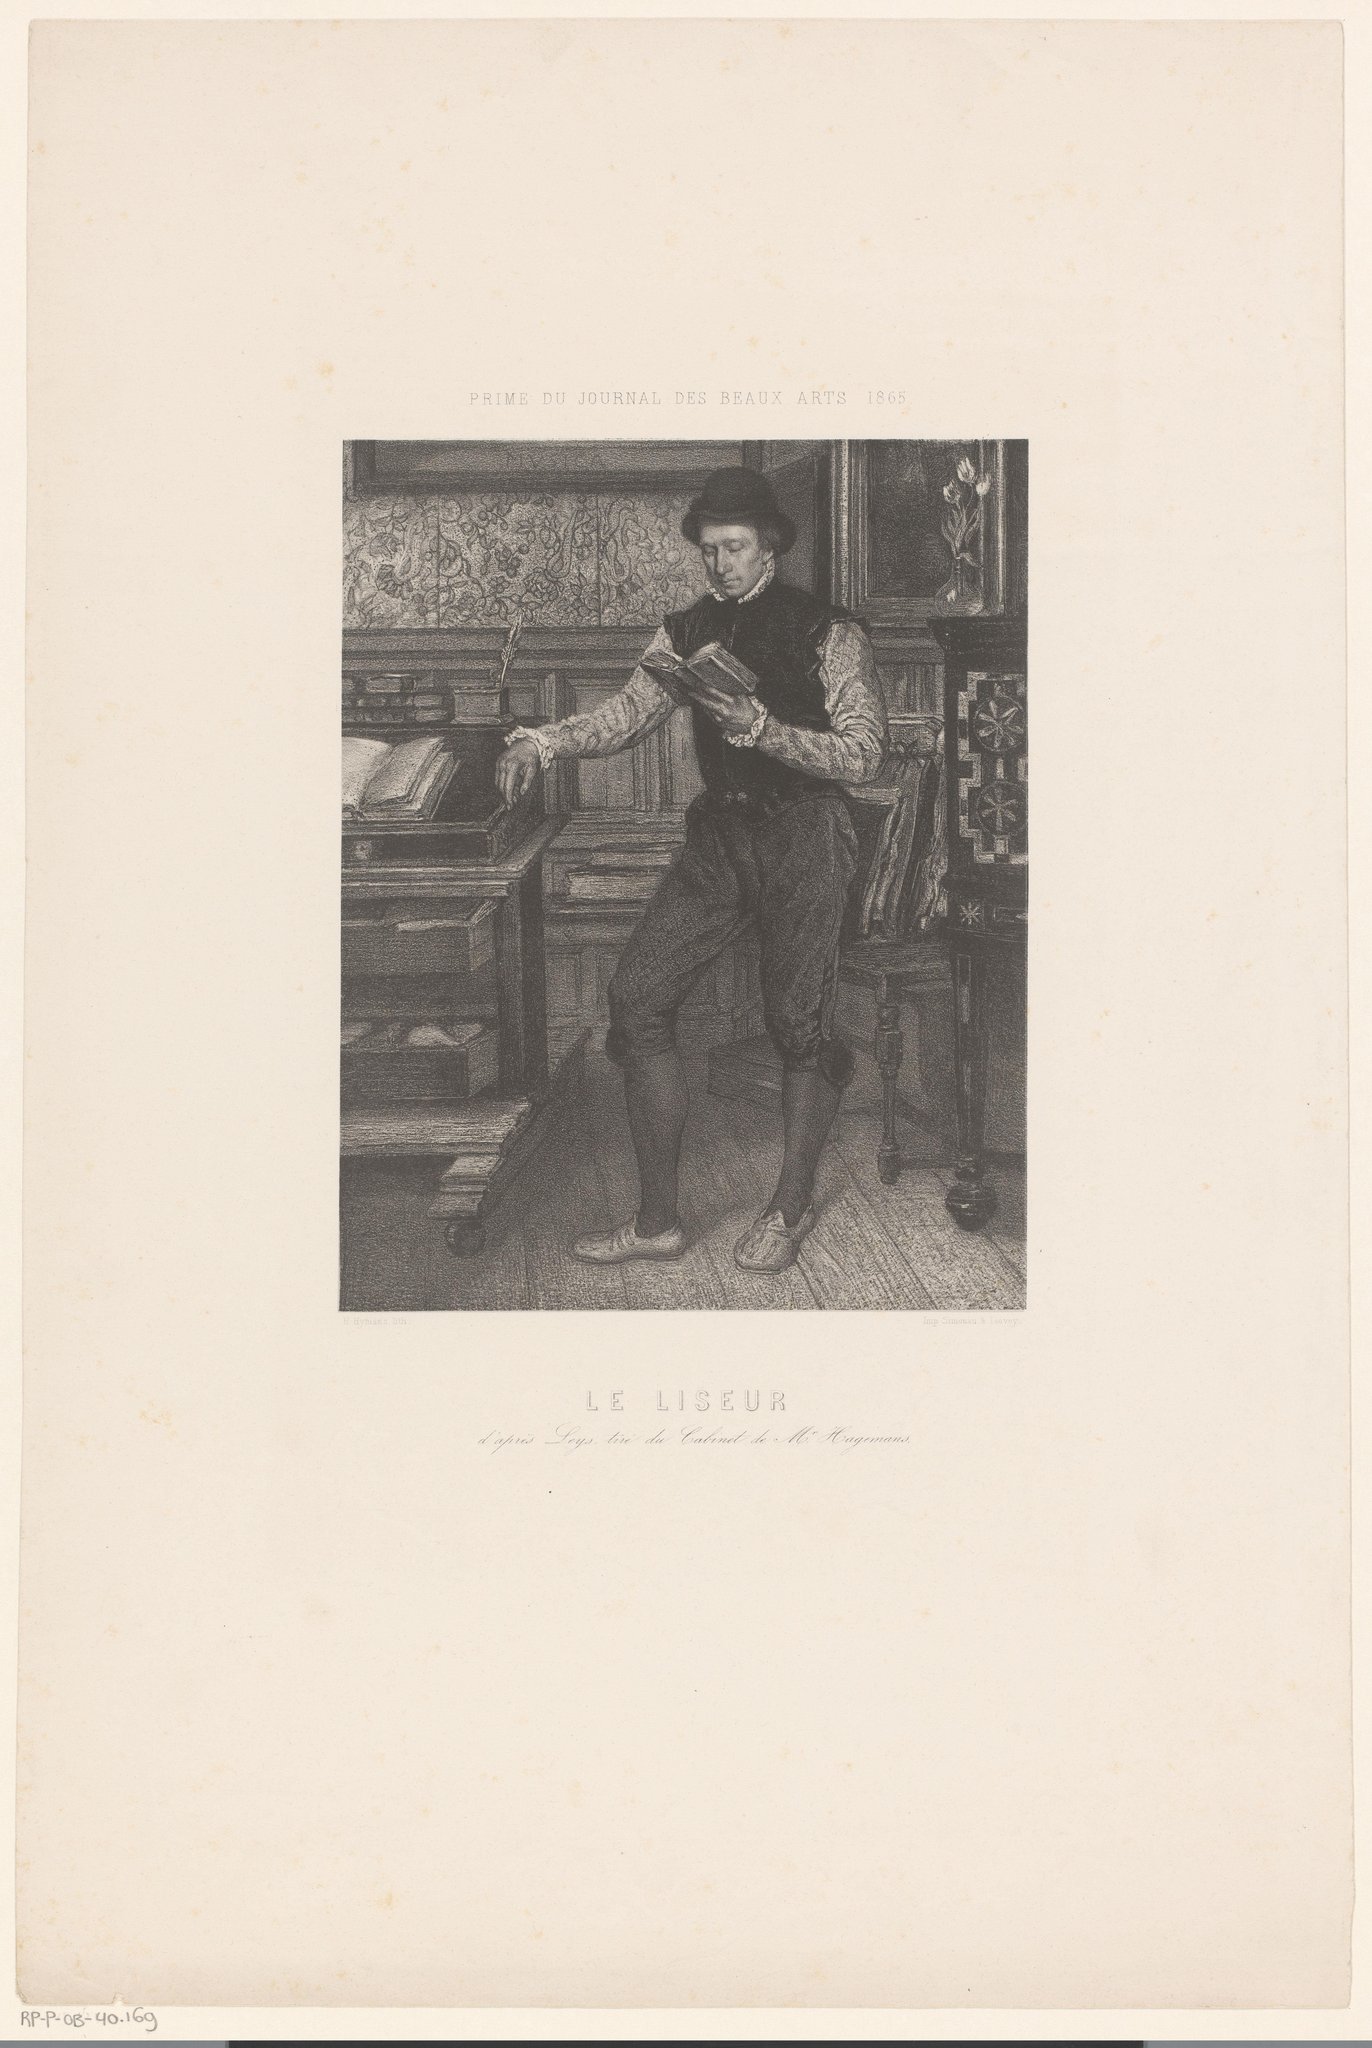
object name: print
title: Le liseur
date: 1865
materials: paper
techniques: lithograph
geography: brussels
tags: writing-table, writing-desk, reading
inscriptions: collector's mark: Lugt 2228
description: Prent uitgegeven als geschenk voor de abonnees van: Journal des Beaux-Arts et de la Littérature no. 20, jaargang 7 (1865).